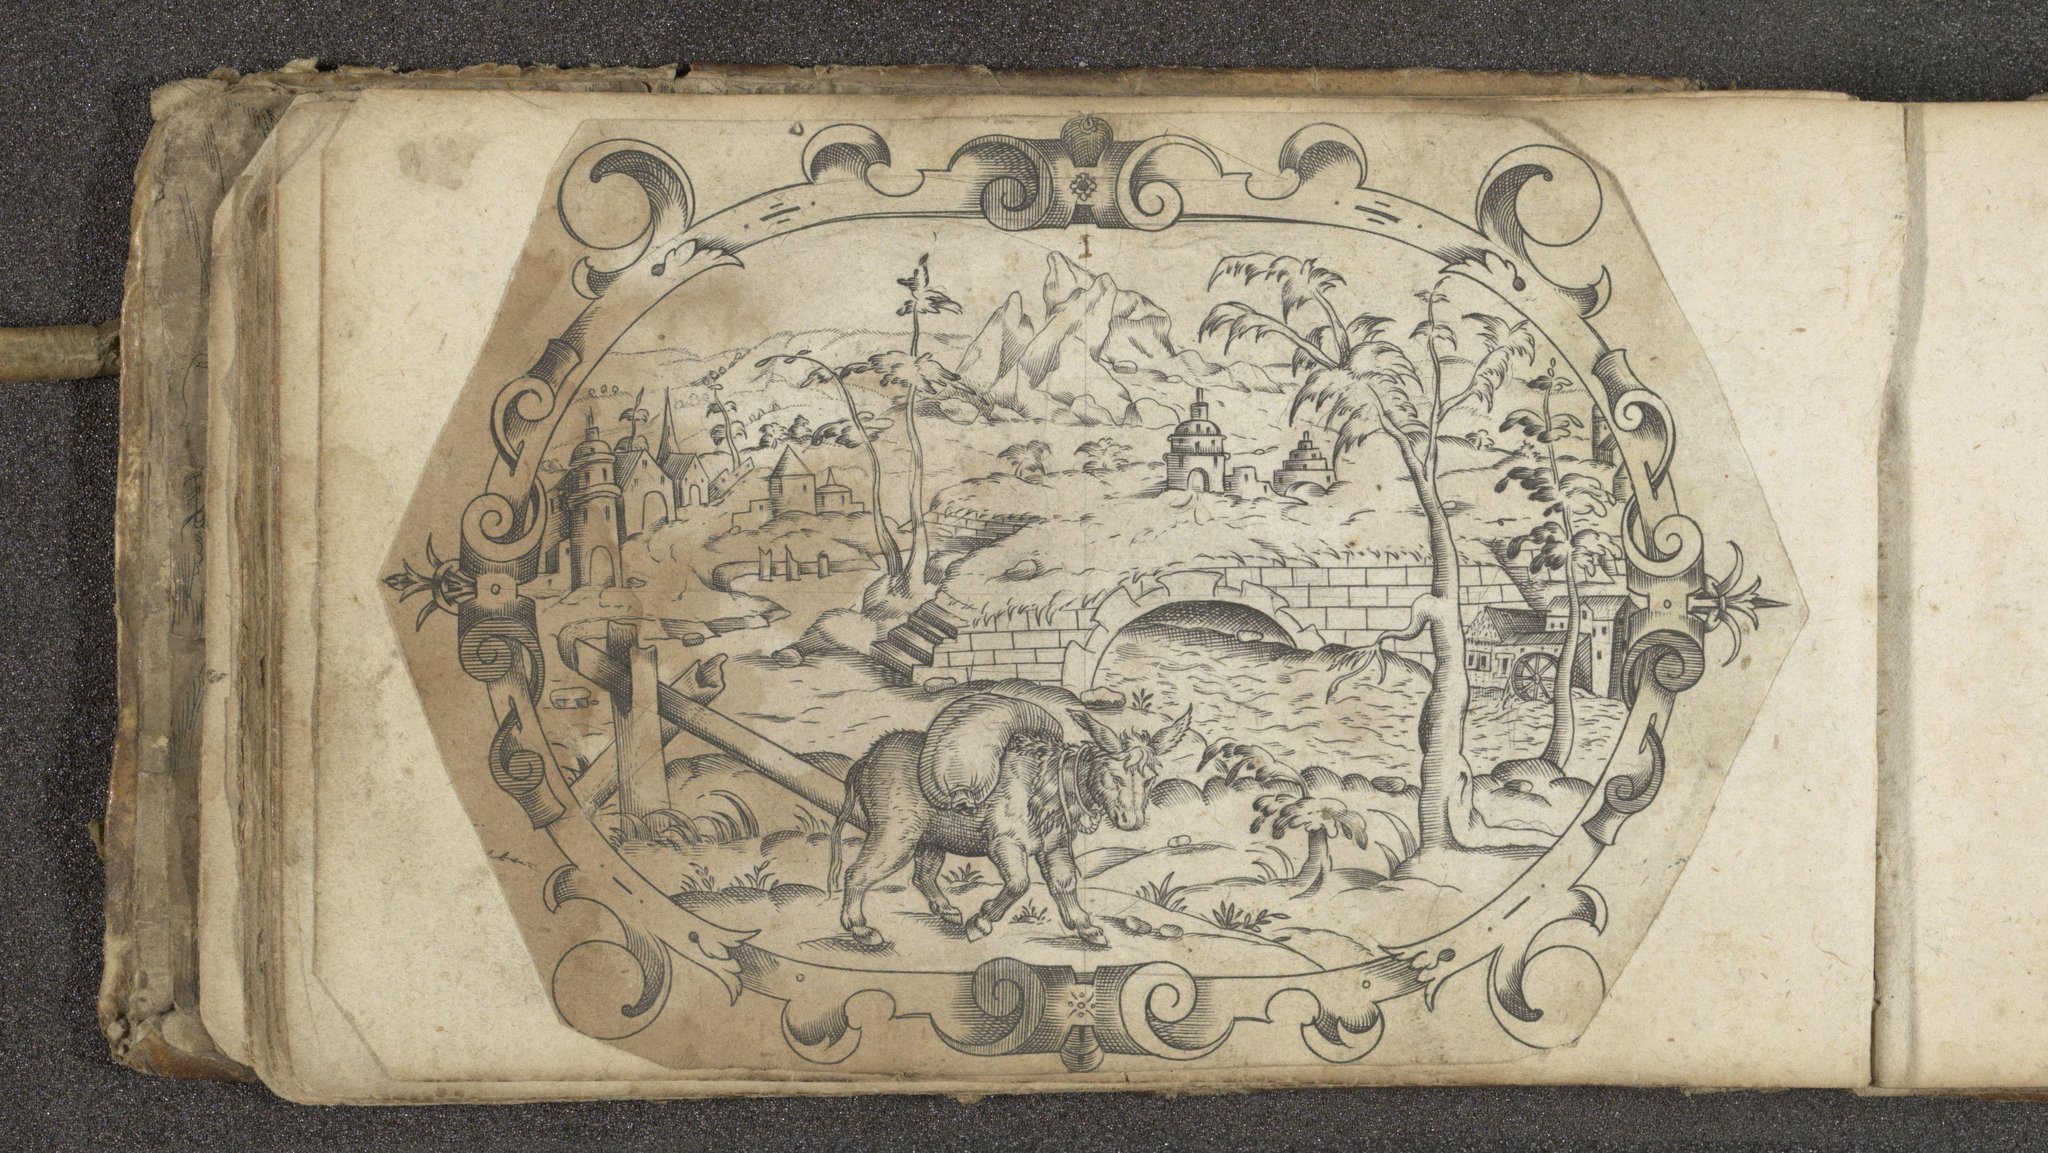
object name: album leaf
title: Cartouches met dieren in landschappen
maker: georg hermann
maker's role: goldsmith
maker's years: 1579-1603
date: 1595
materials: paper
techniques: engraving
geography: ansbach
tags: ass, donkey, landscape with bridge, viaduct or aqueduct, ornament ~ cartouche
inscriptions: inscription: ‘38’, inscription: ‘1’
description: Rolwerk cartouche met een ezel in een landschap met een stenen brug. De prent maakt deel uit van een album.